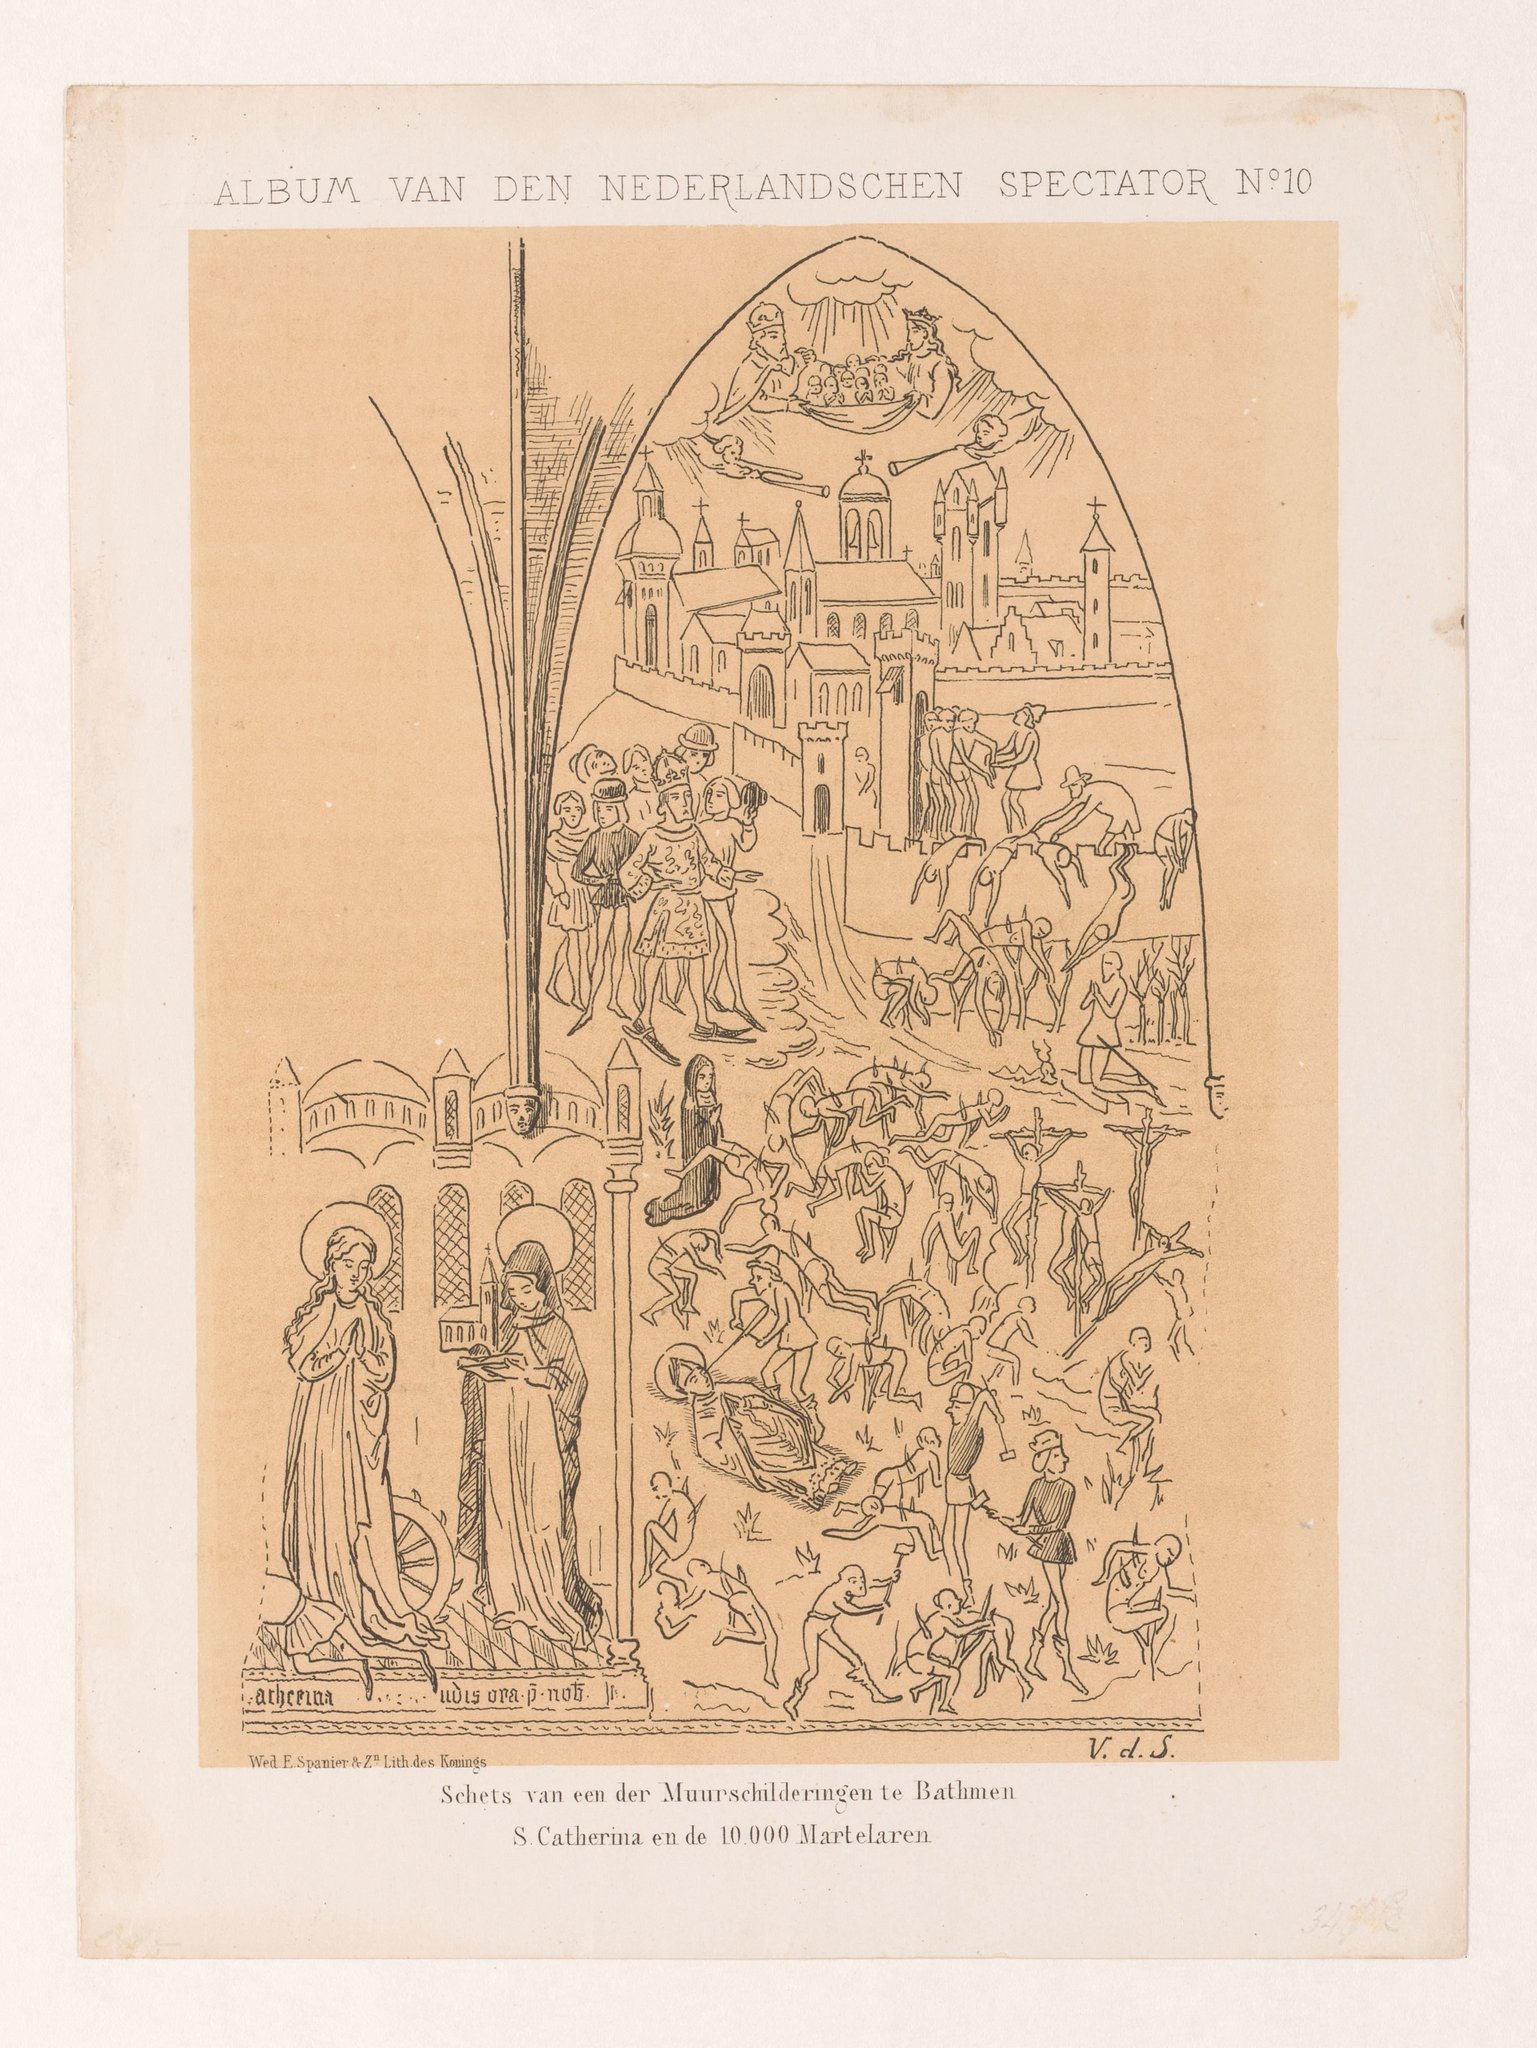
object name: print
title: Schets van een der muurschilderingen te Bathmen. S. Catherina en de 10.000 Martelaren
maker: jonkheer victor eugène louis de stuers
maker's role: draughtsman, print maker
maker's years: 1843-1916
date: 1869-1871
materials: paper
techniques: tone lithography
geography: the hague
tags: picture, painting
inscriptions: collector's mark: Lugt 2228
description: Prent uit: Album van den Nederlandschen Spectator, Arnhem 1869-1871, No. 10.